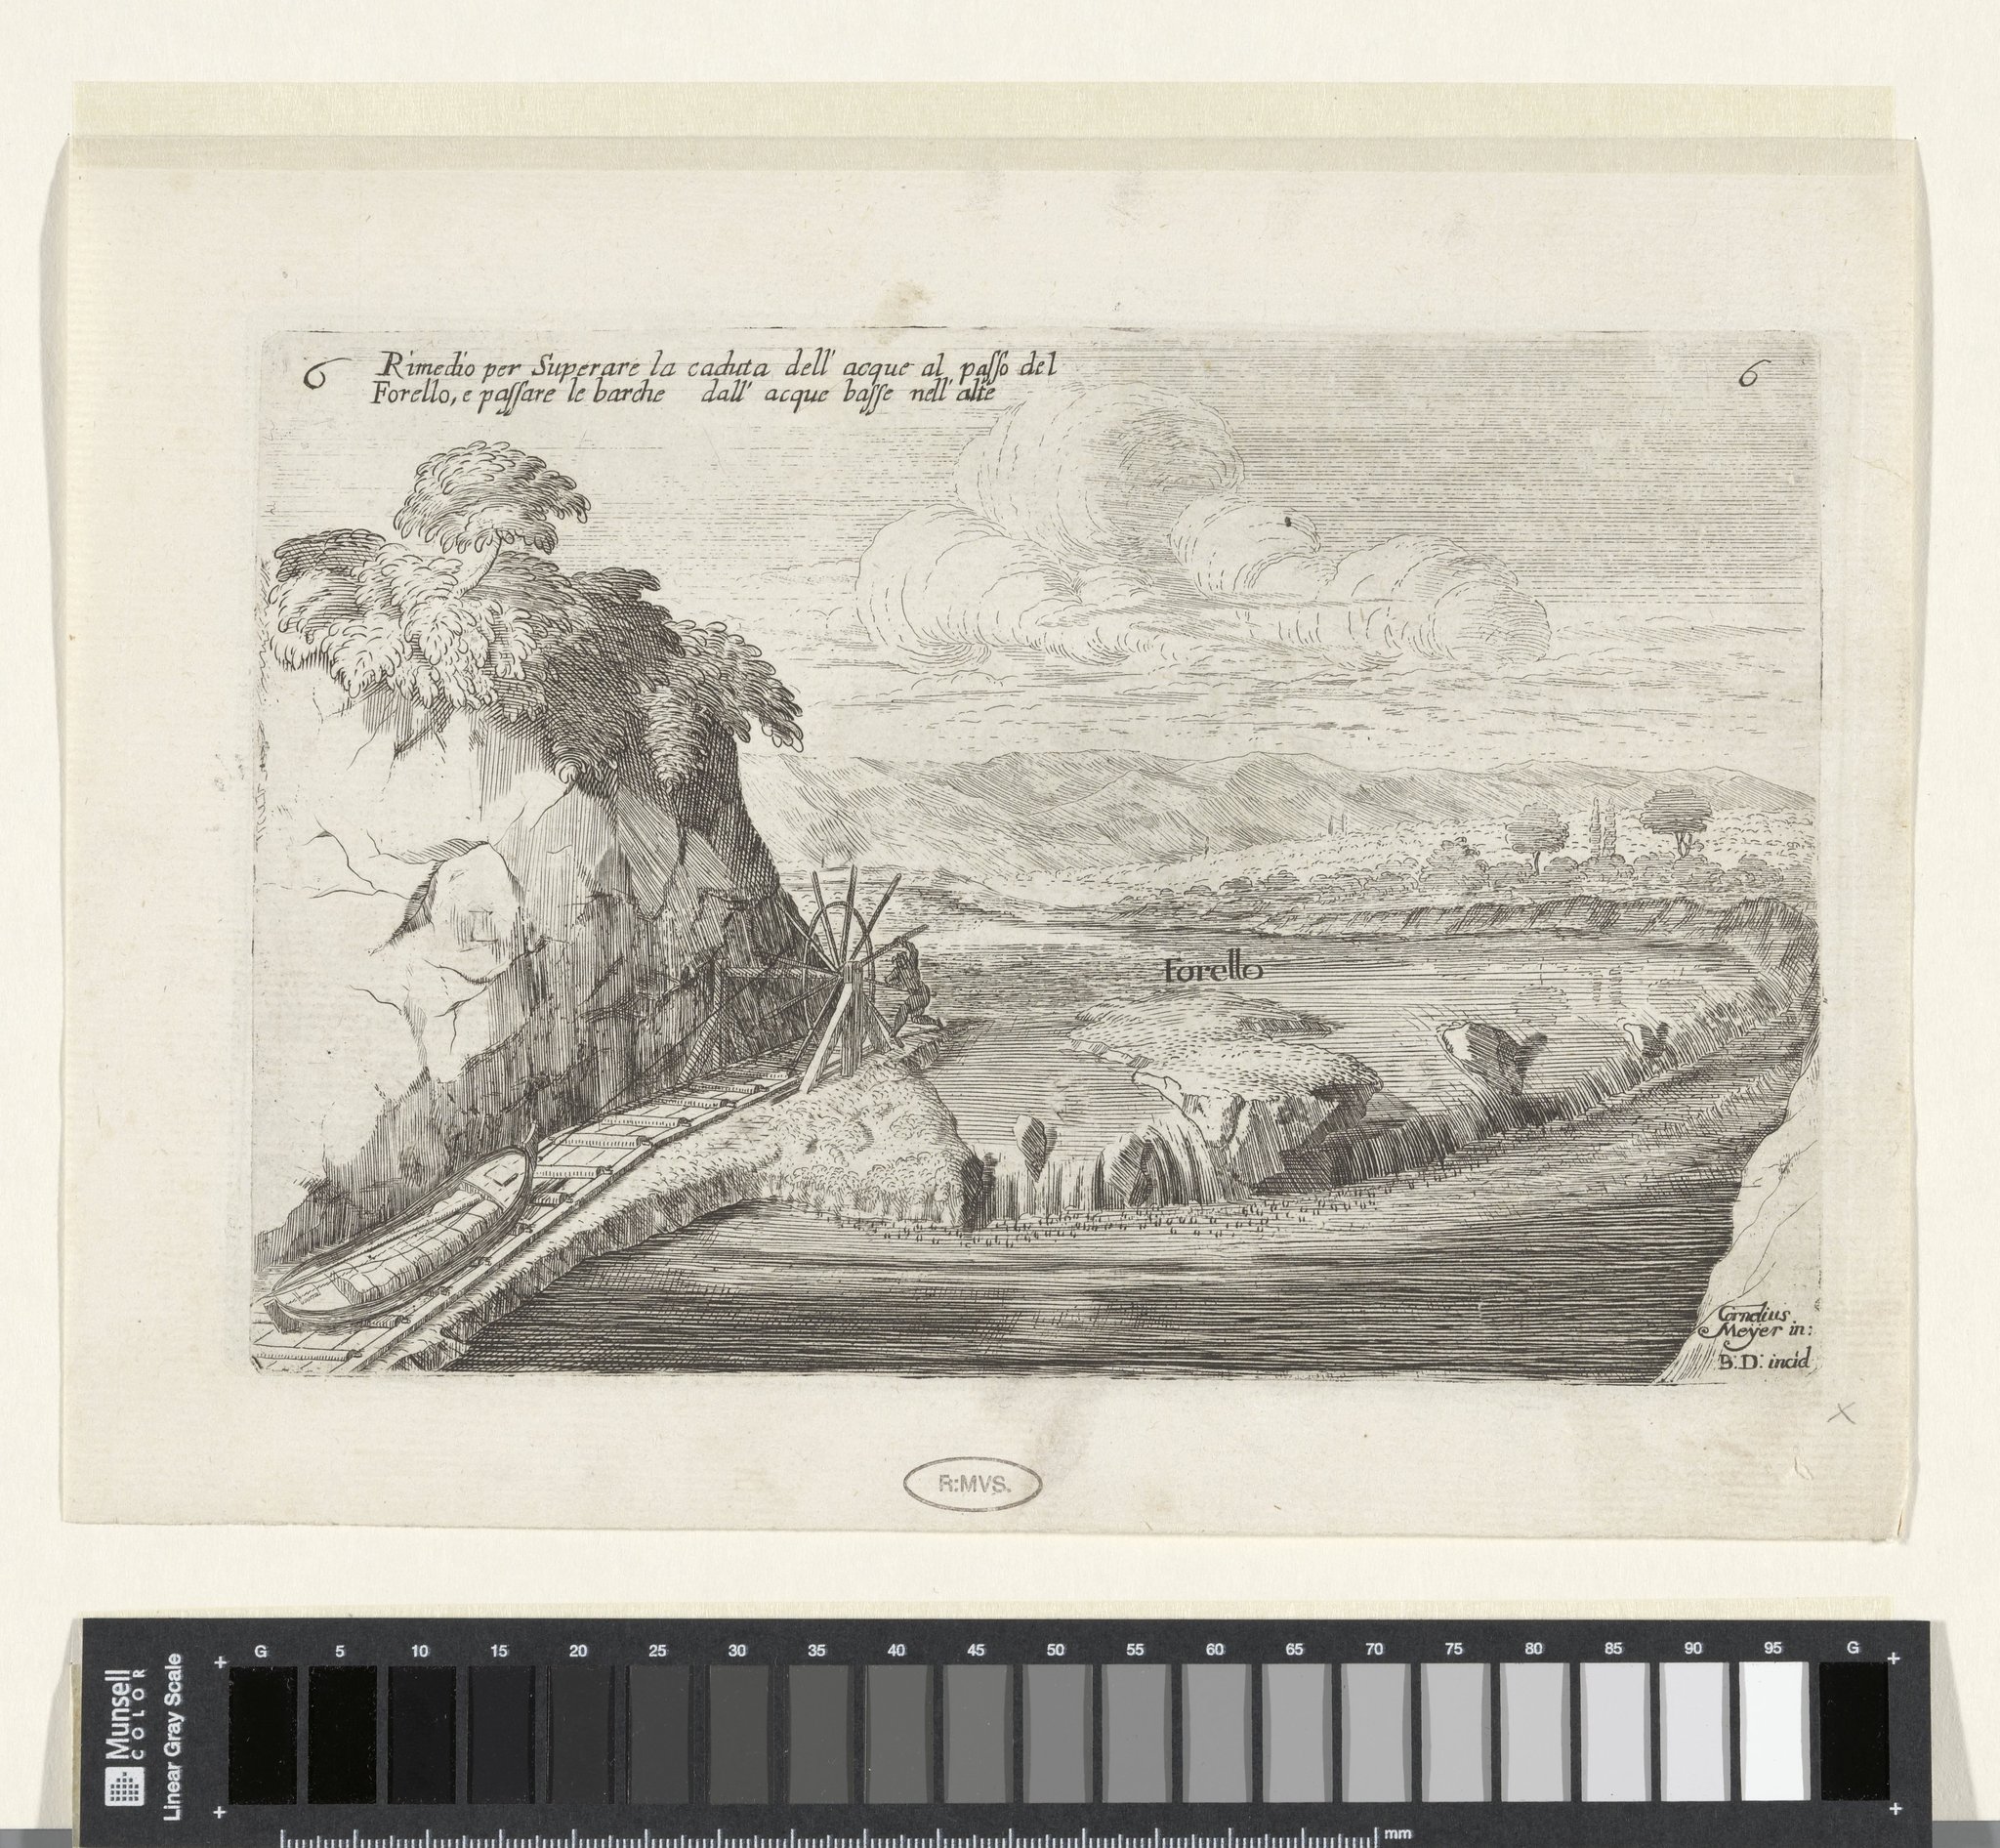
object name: print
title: L'arte di rendere i fiumi navigabili, in varij modi, con altre nuove inventioni, e varij altri segreti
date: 1677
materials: paper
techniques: etching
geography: italy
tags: river, working class, labourers, rolling bridge (dutch: 'overtoom')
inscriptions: collector's mark: Lugt 2228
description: Deze prent maakte oorspronkelijk deel uit van een publicatie bestaande uit drie delen, uitgegeven door G.G. Komarek in Rome in 1696. Het eerste deel zit achter een titelpagina met de titel: L'arte di rendere i fiumi navigabili, in varij modi, con altre nuove inventioni, e varij altri segreti. Deel twee zit achter een titelpagina met de titel: Racolta di varii segreti come si vedono nelle segventi figure. Deel drie zit achter een titelpagina met de titel: Osservazioni delle comete che dovranno seguire, e dell'ecclisse del primo satellite di Giove, et altre propositioni prosicue da farsi per commodo & ornamento della città. Deze prent komt uit het eerste deel. Prenten in de publicatie zijn naar ontwerp van Cornelis Meijer gemaakt door verschillende prentmakers, onder wie G.B. Falda, G. van Wittel, Gomar Wouters, etc. Er is ook een eerdere versie bekend van deze publicatie, uitgegeven in Rome in 1683, met de titel: L'arte di restituire a Roma la tralasciata navigazione del suo Tevere.